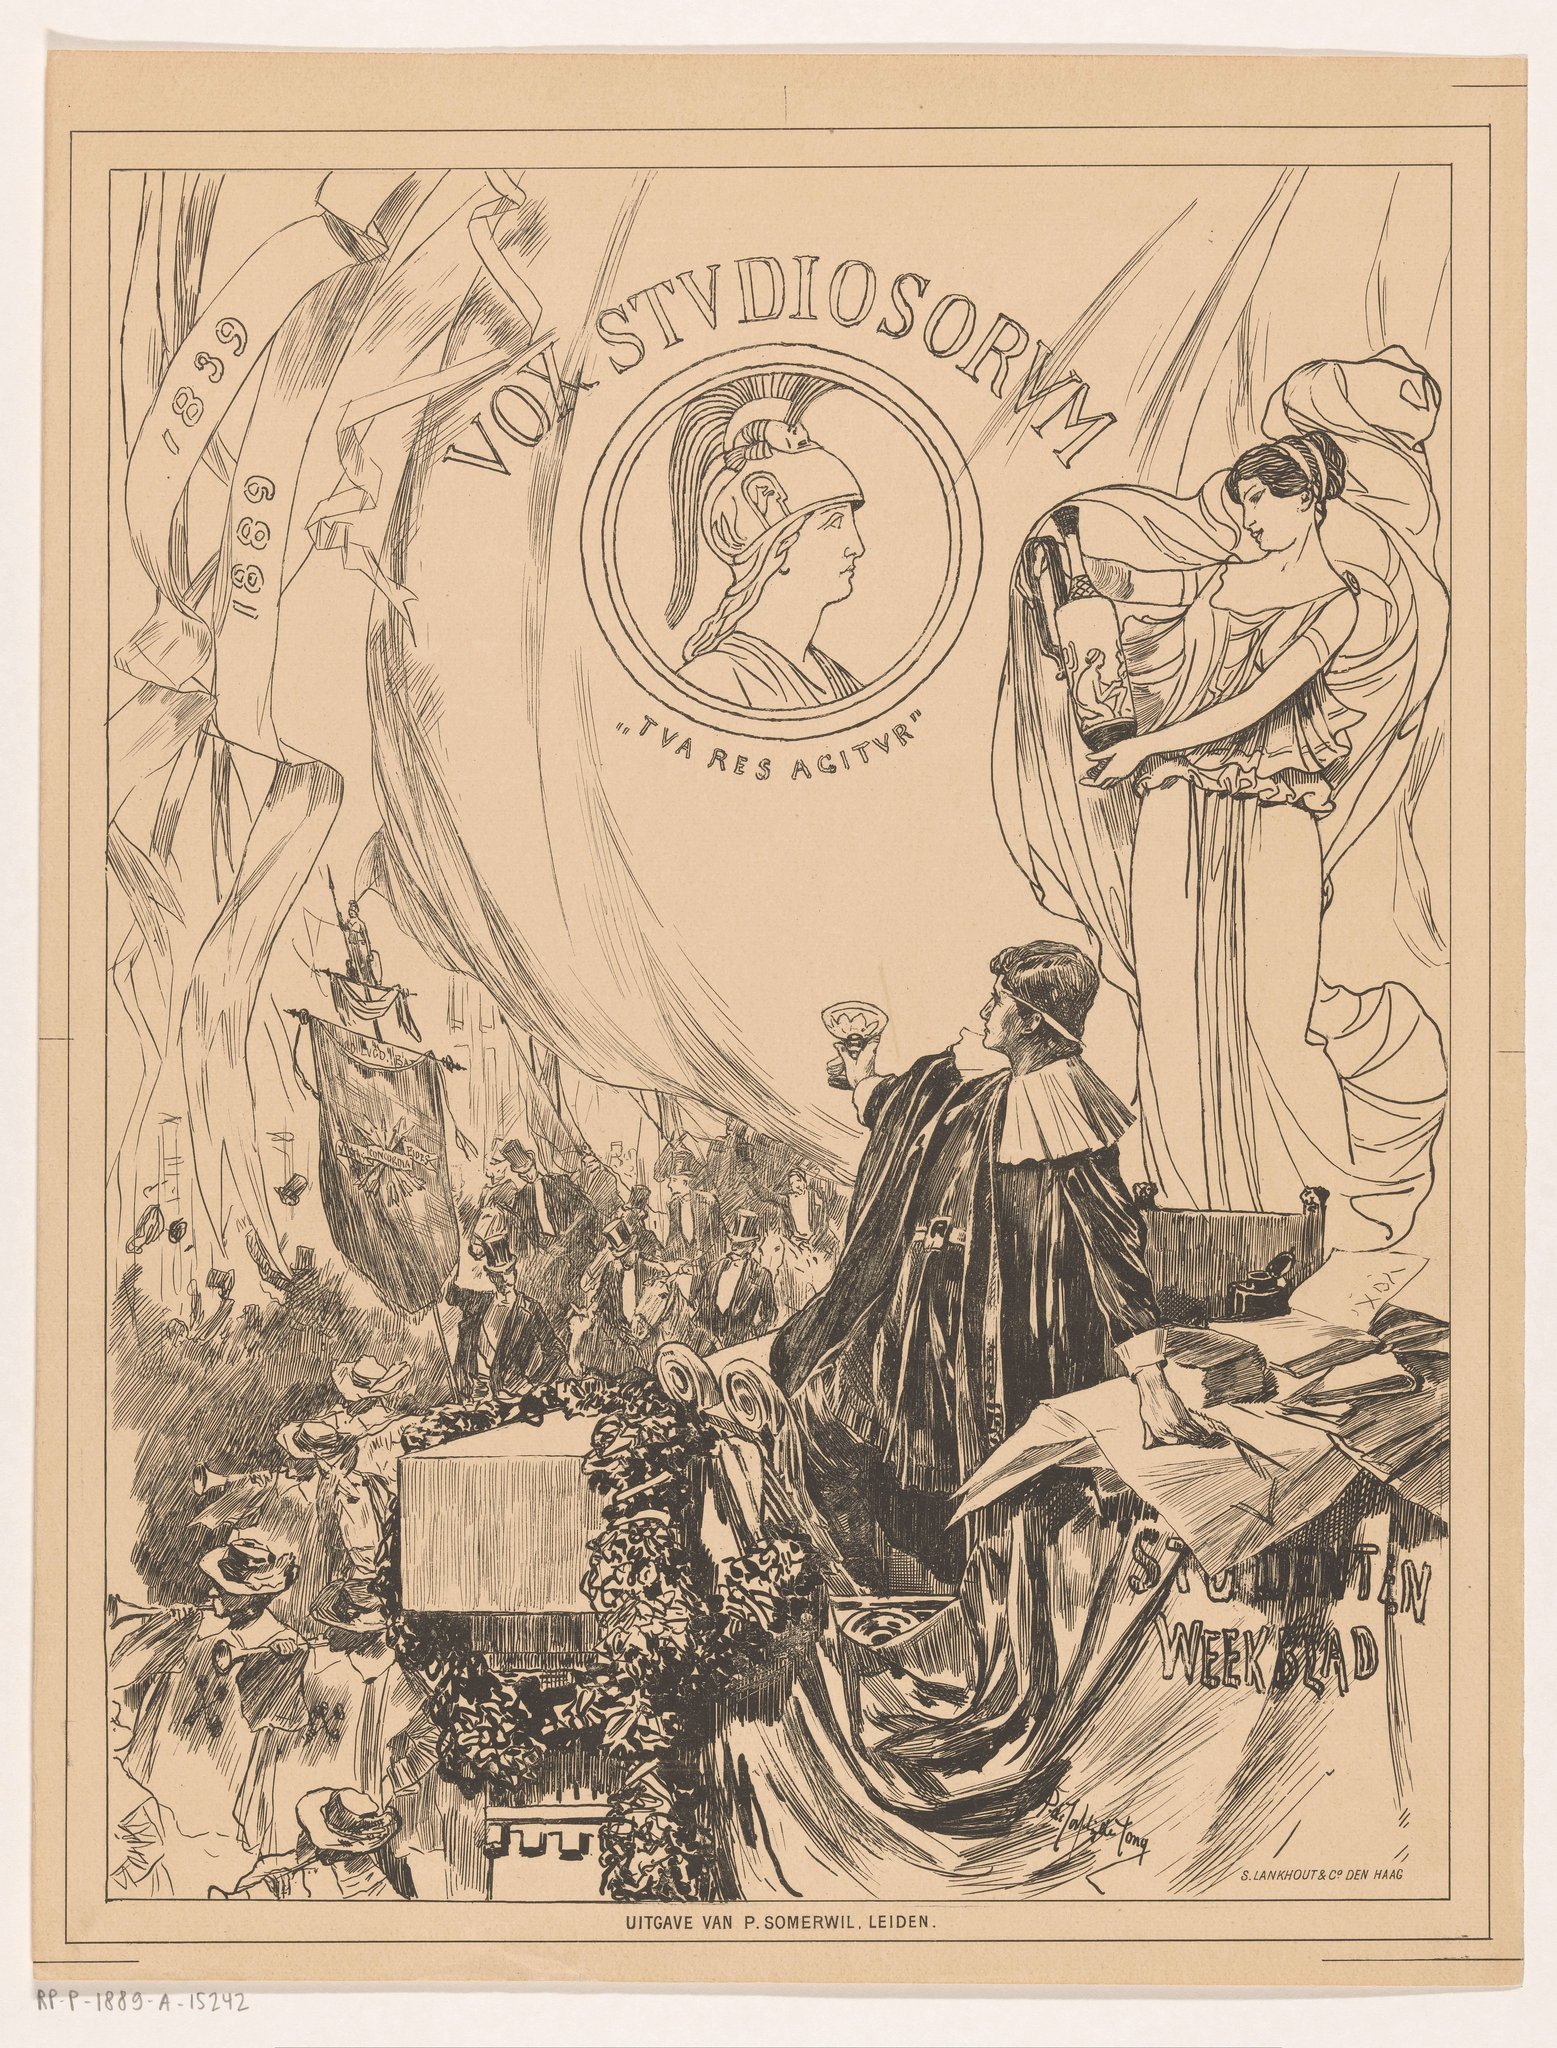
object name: print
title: Gedenkblad van Vox Studiosorum, ter gelegenheid van het 50 jarig bestaan der Studentensocieteit Minerva te Leiden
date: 1889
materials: paper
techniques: lithograph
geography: leiden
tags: (story of) minerva (pallas, athena)